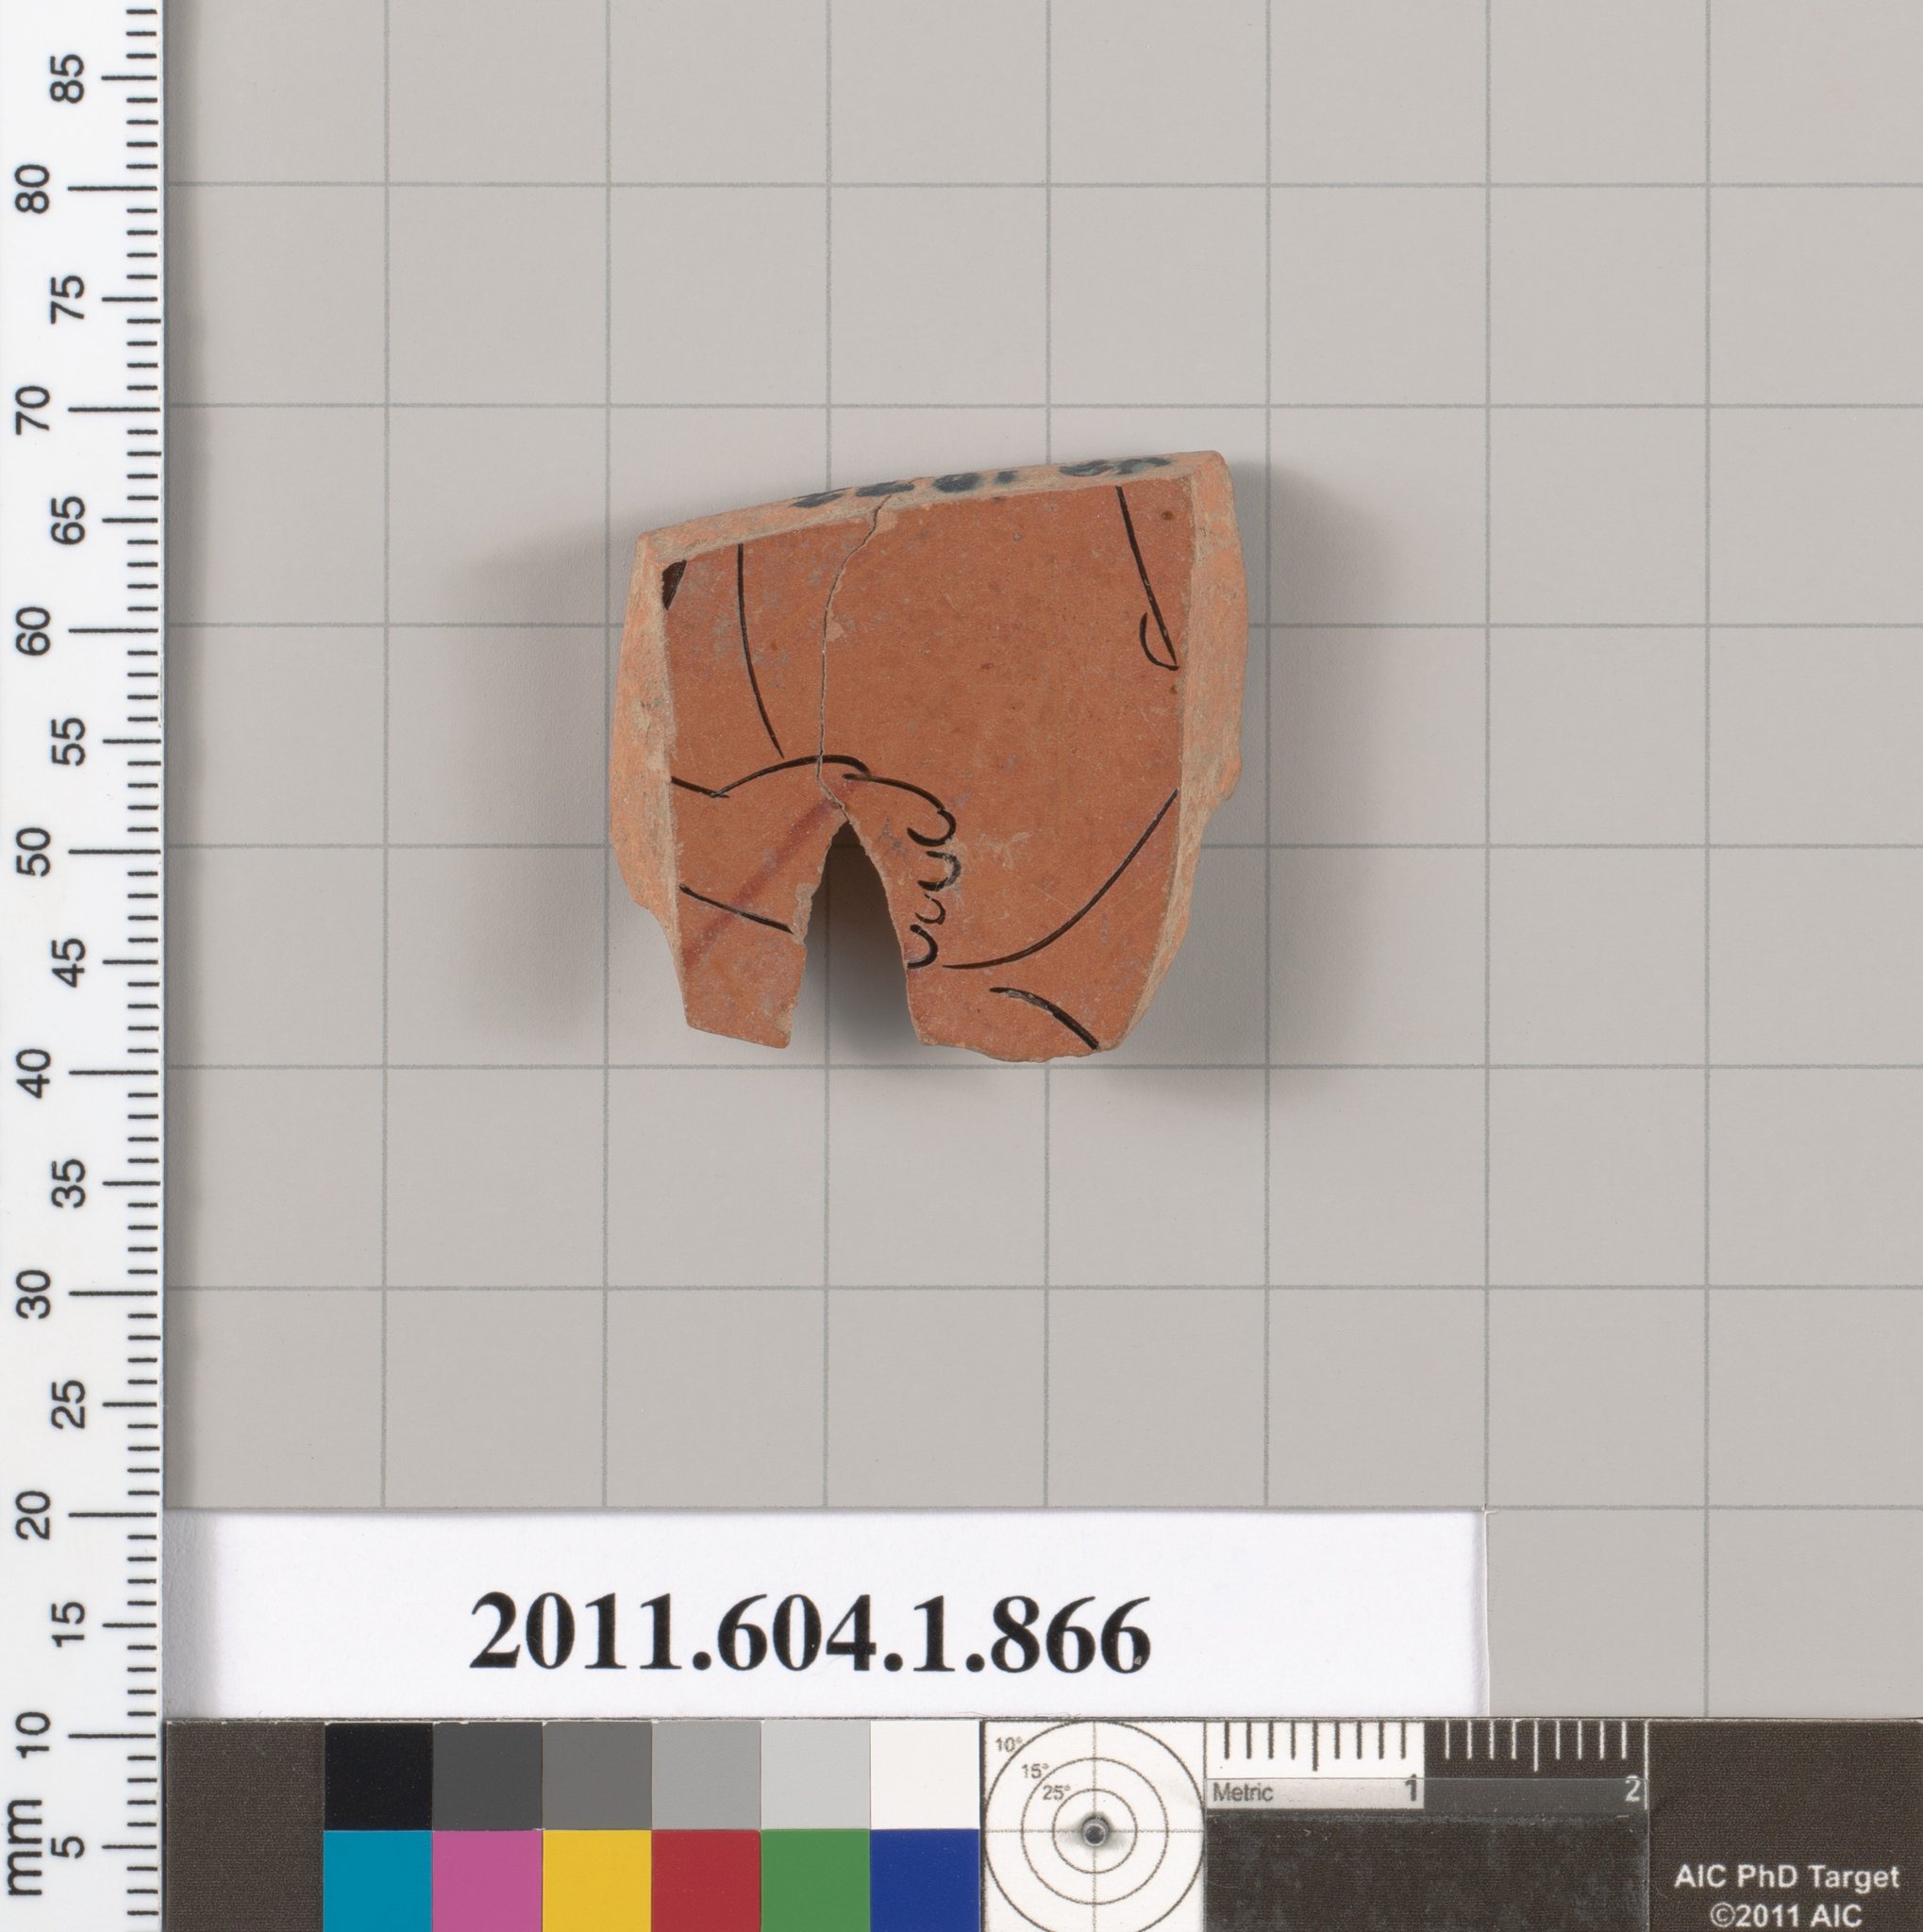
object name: kylix fragment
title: Terracotta fragment of a kylix (drinking cup)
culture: greek, attic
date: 475-451 BCE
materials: terracotta